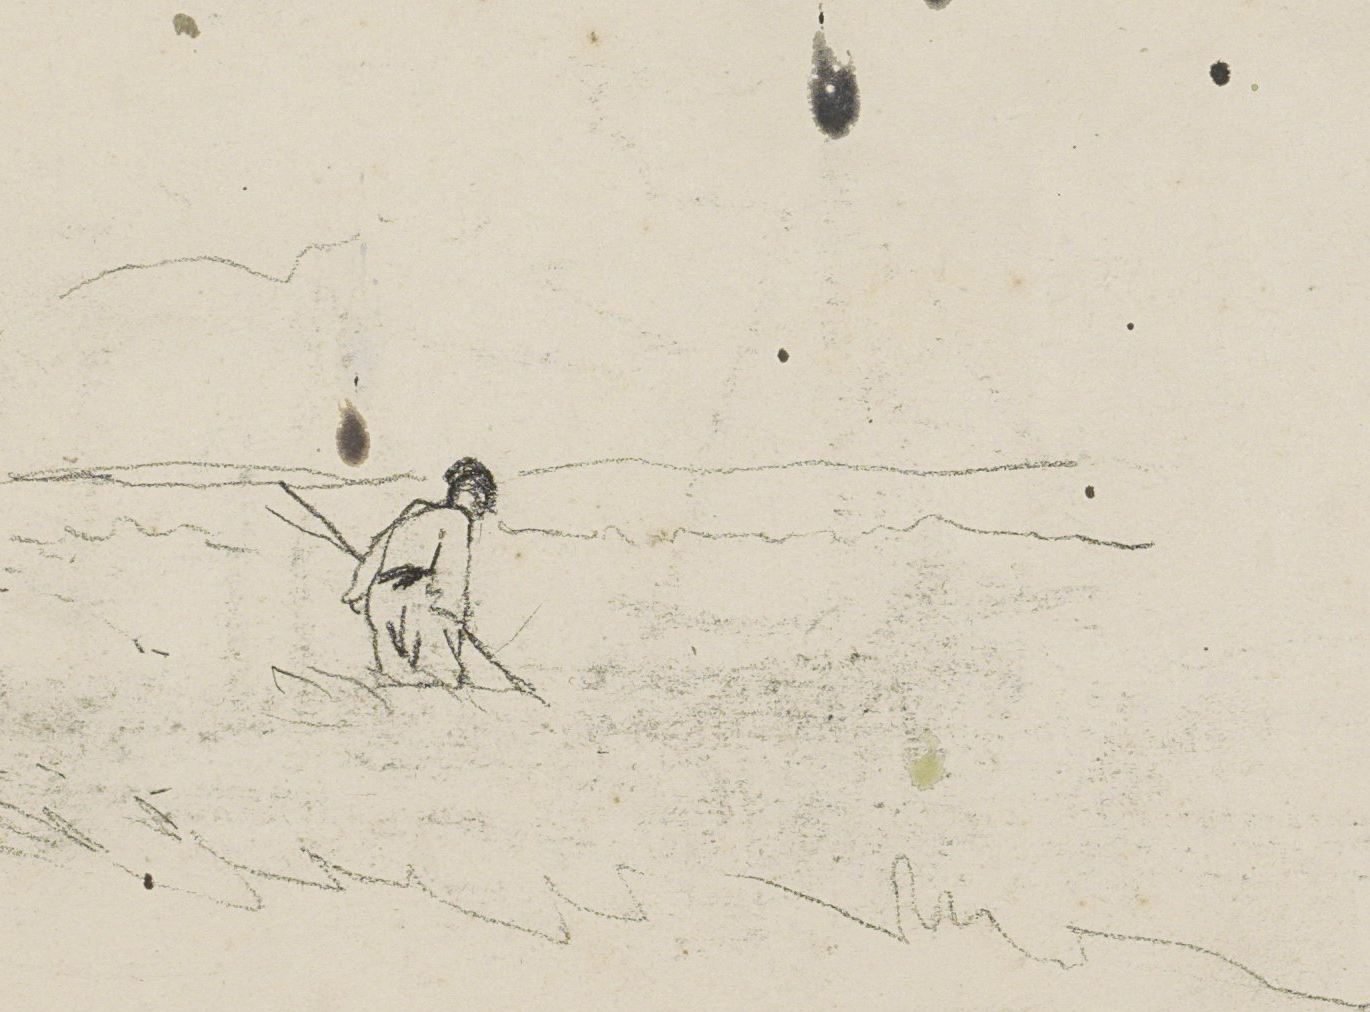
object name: sketchbook leaf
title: Schelpenvisser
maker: anton mauve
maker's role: draughtsman, painter, print maker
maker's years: 1838-1888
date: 1848-1888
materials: chalk, paper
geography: scheveningen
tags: fisherman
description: De man staat tot boven de knieeën in zee met een stok, vermoedelijk met een net eraan, in de hand. Blad 12 verso uit een schetsboek met 33 bladen.